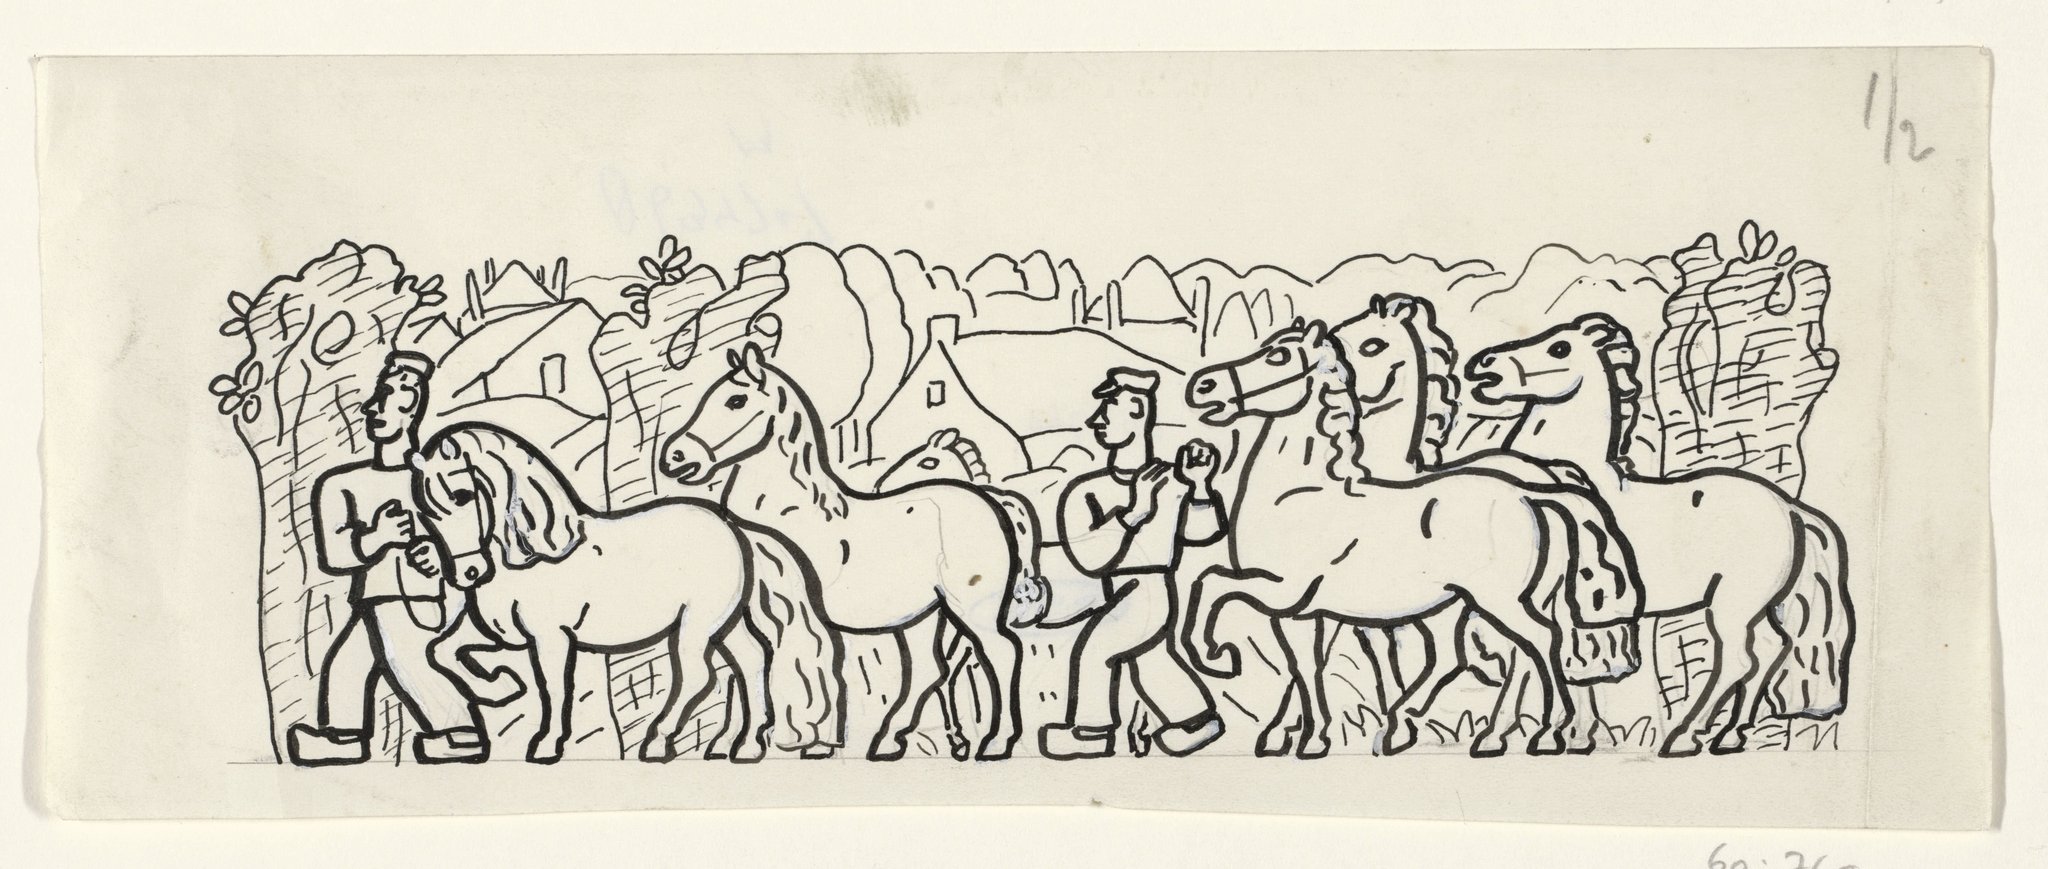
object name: drawing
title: Twee boeren leiden hun paarden door een dorp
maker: leo gestel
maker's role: draughtsman, print maker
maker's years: 1881-1941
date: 1891-1941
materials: paint, ink, paper, pencil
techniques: brush, pen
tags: farmers, horse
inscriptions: collector's mark: Lugt 2228